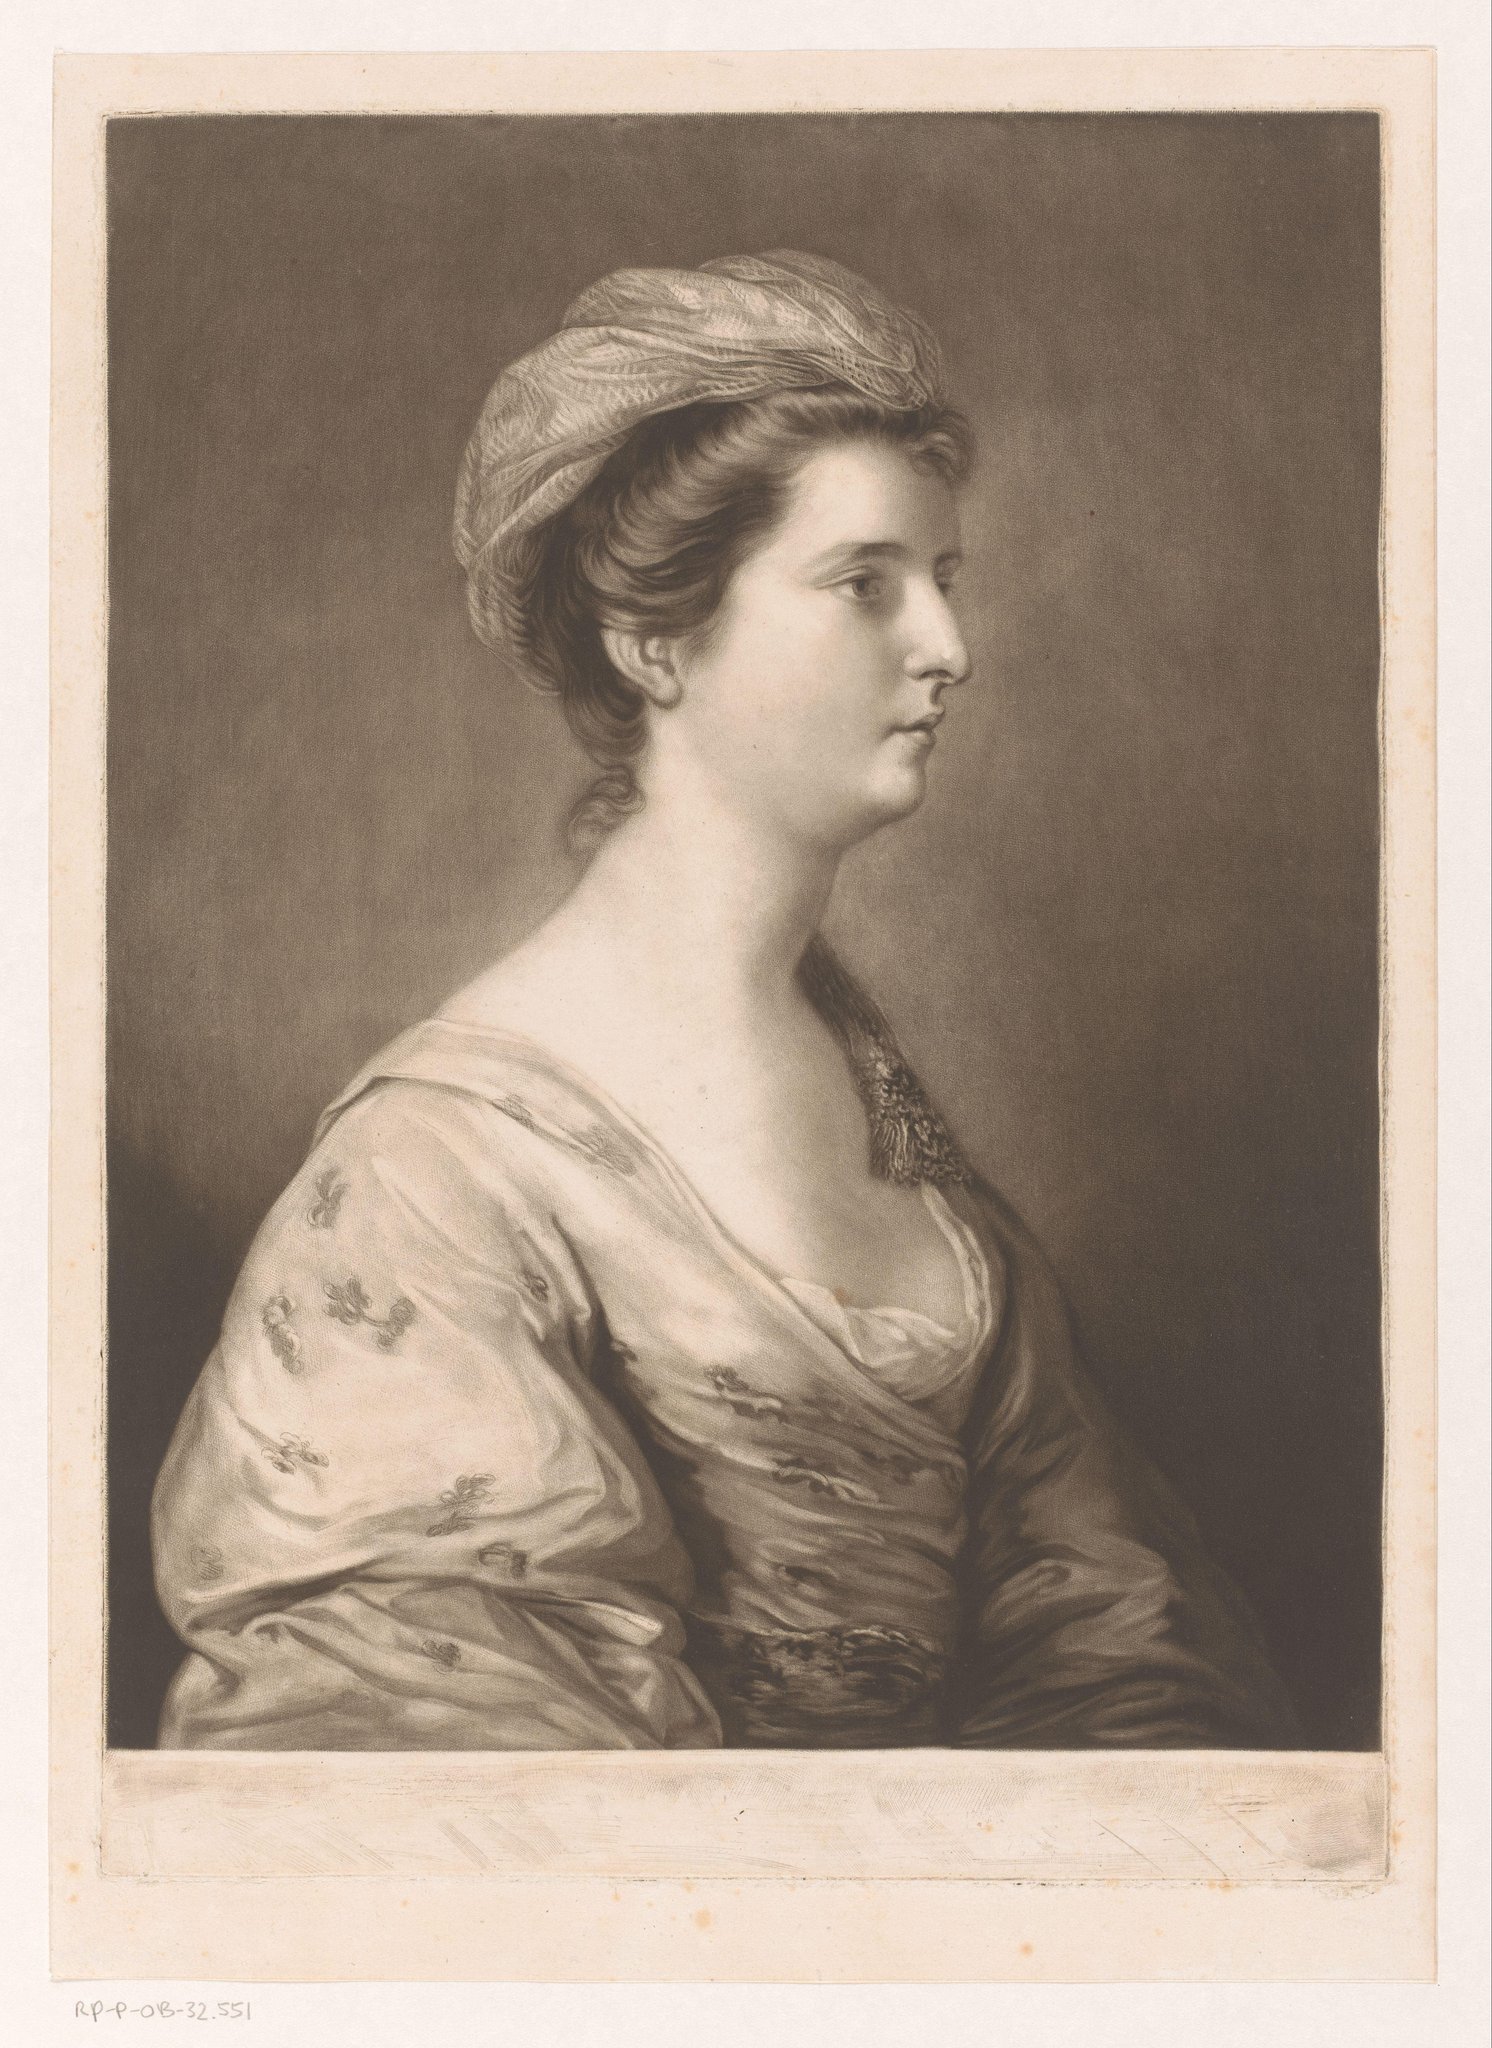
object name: print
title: Portret van Maria Walpole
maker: james mcardell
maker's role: print maker, publisher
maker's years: 1728-1765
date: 1762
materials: paper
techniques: mezzotint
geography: london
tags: historical persons - bb - woman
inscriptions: collector's mark: Lugt 240